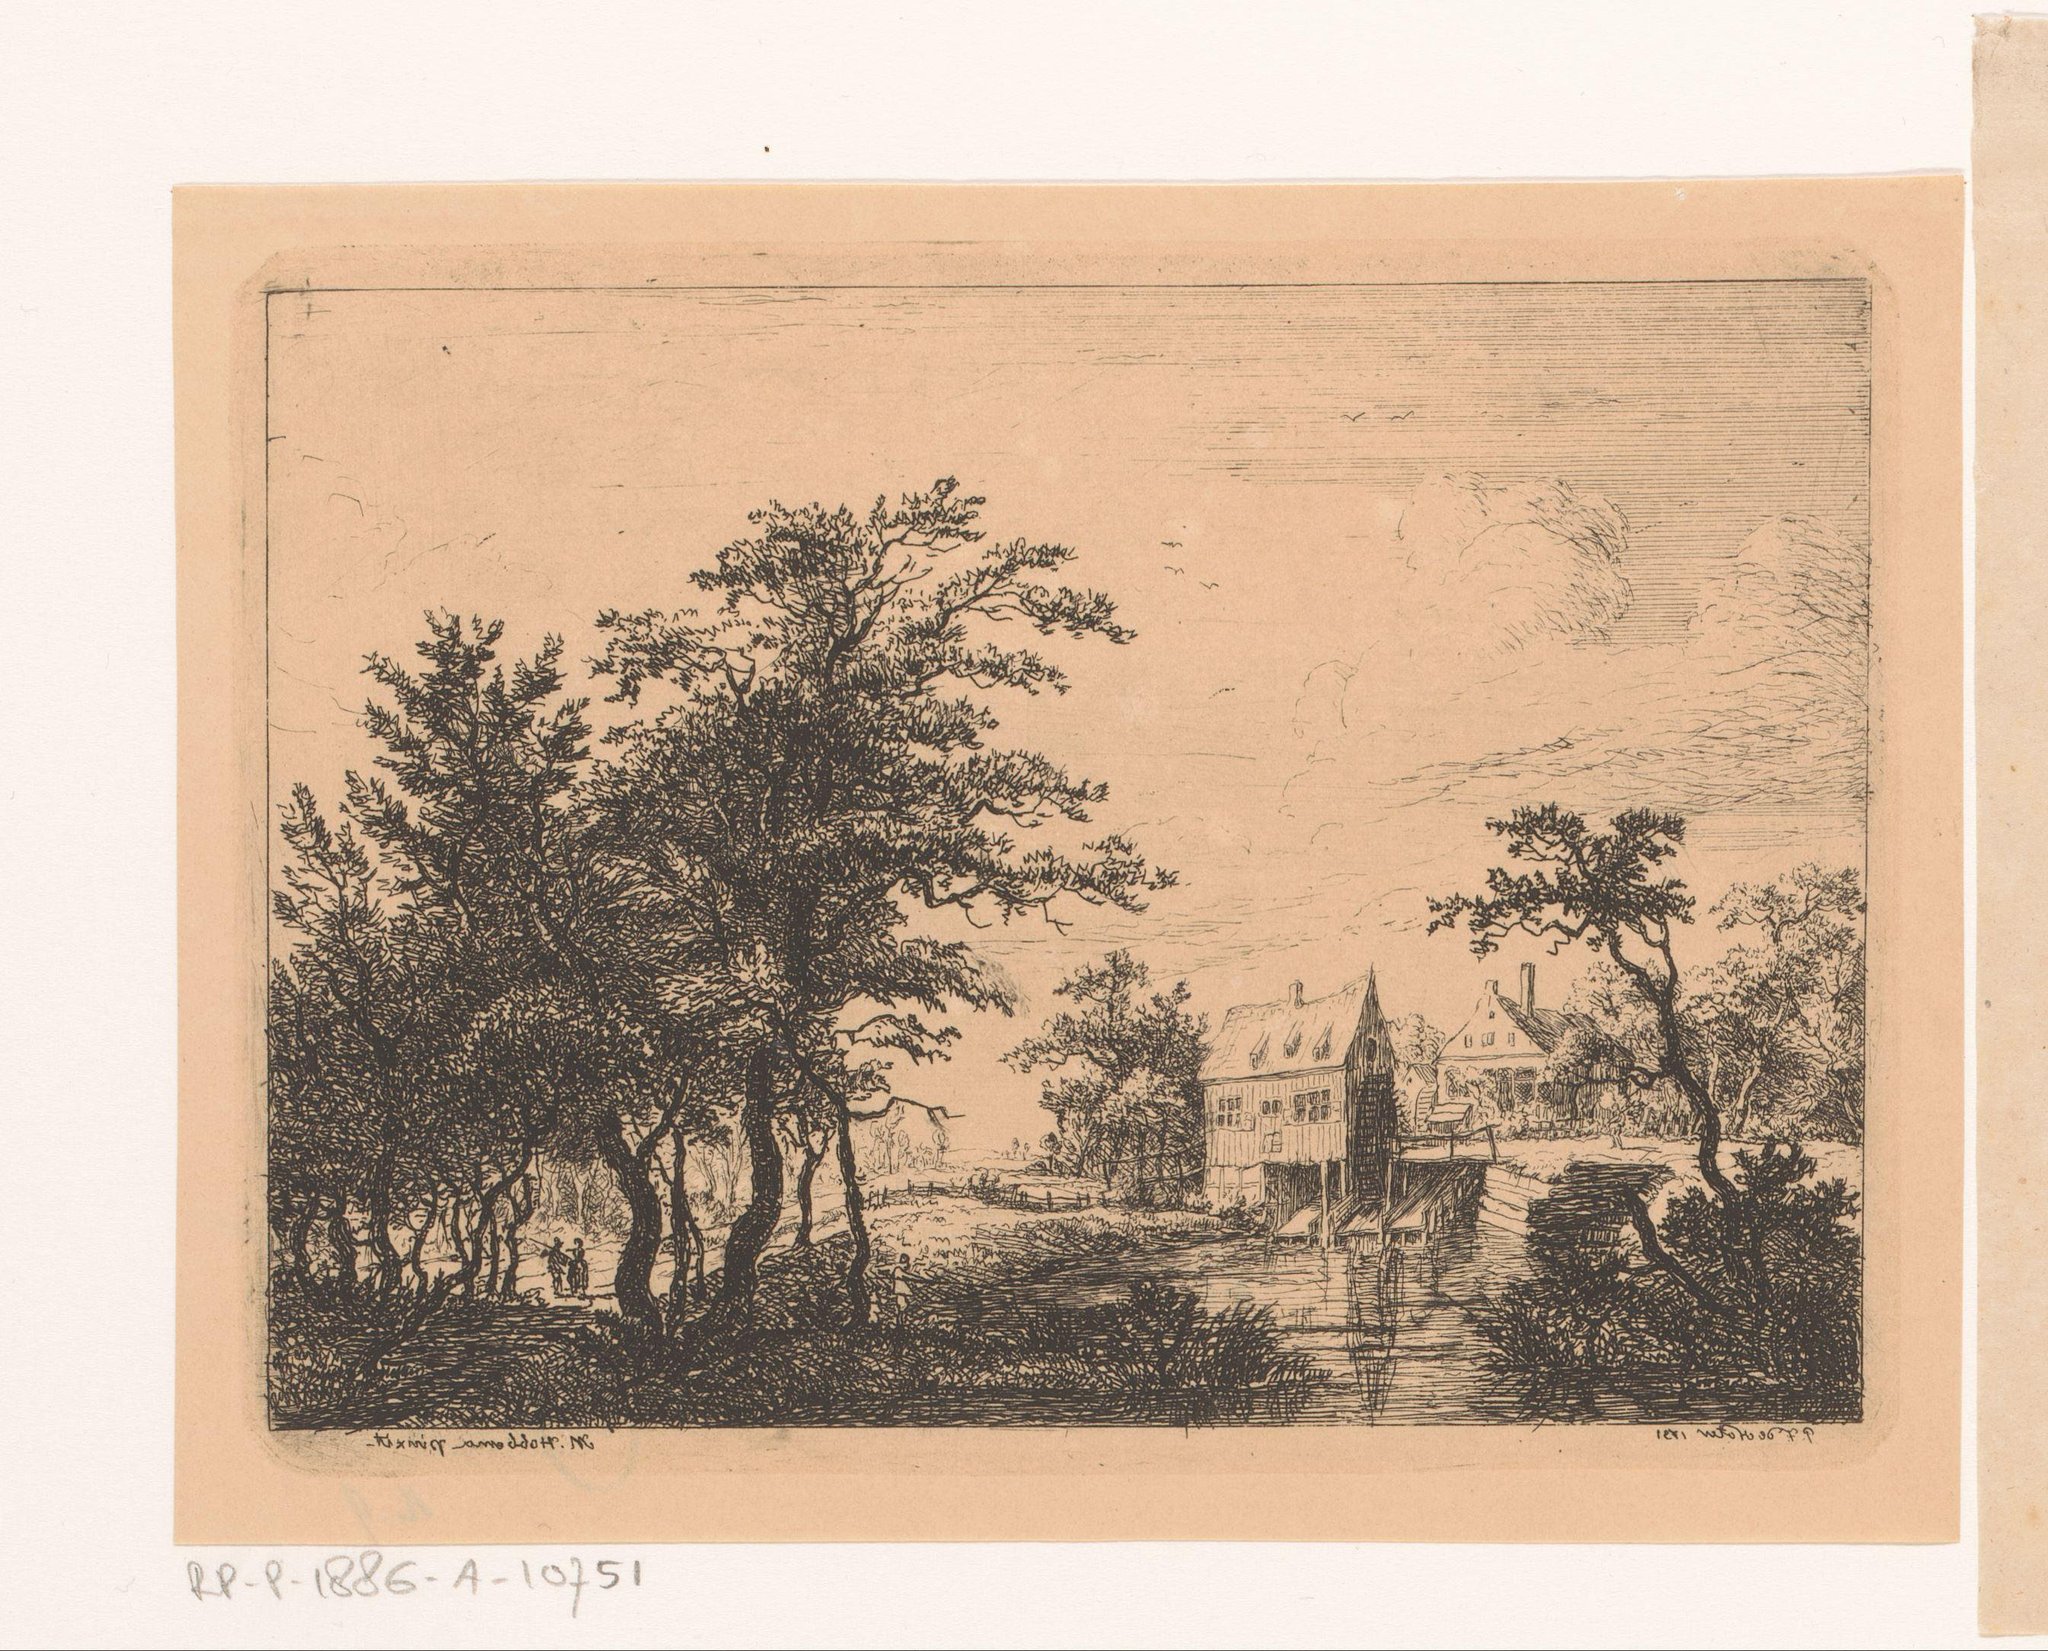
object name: print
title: Recueil de gravures à l'eau forte, dont plusieurs d'apres Hobbema, par P.F. de Noter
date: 1831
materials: paper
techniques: etching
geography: ghent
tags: watermill in landscape, landscapes with waters, waterscapes, seascapes (in the temperate zone) (+ landscape with figures, staffage)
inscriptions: collector's mark: Lugt 2228